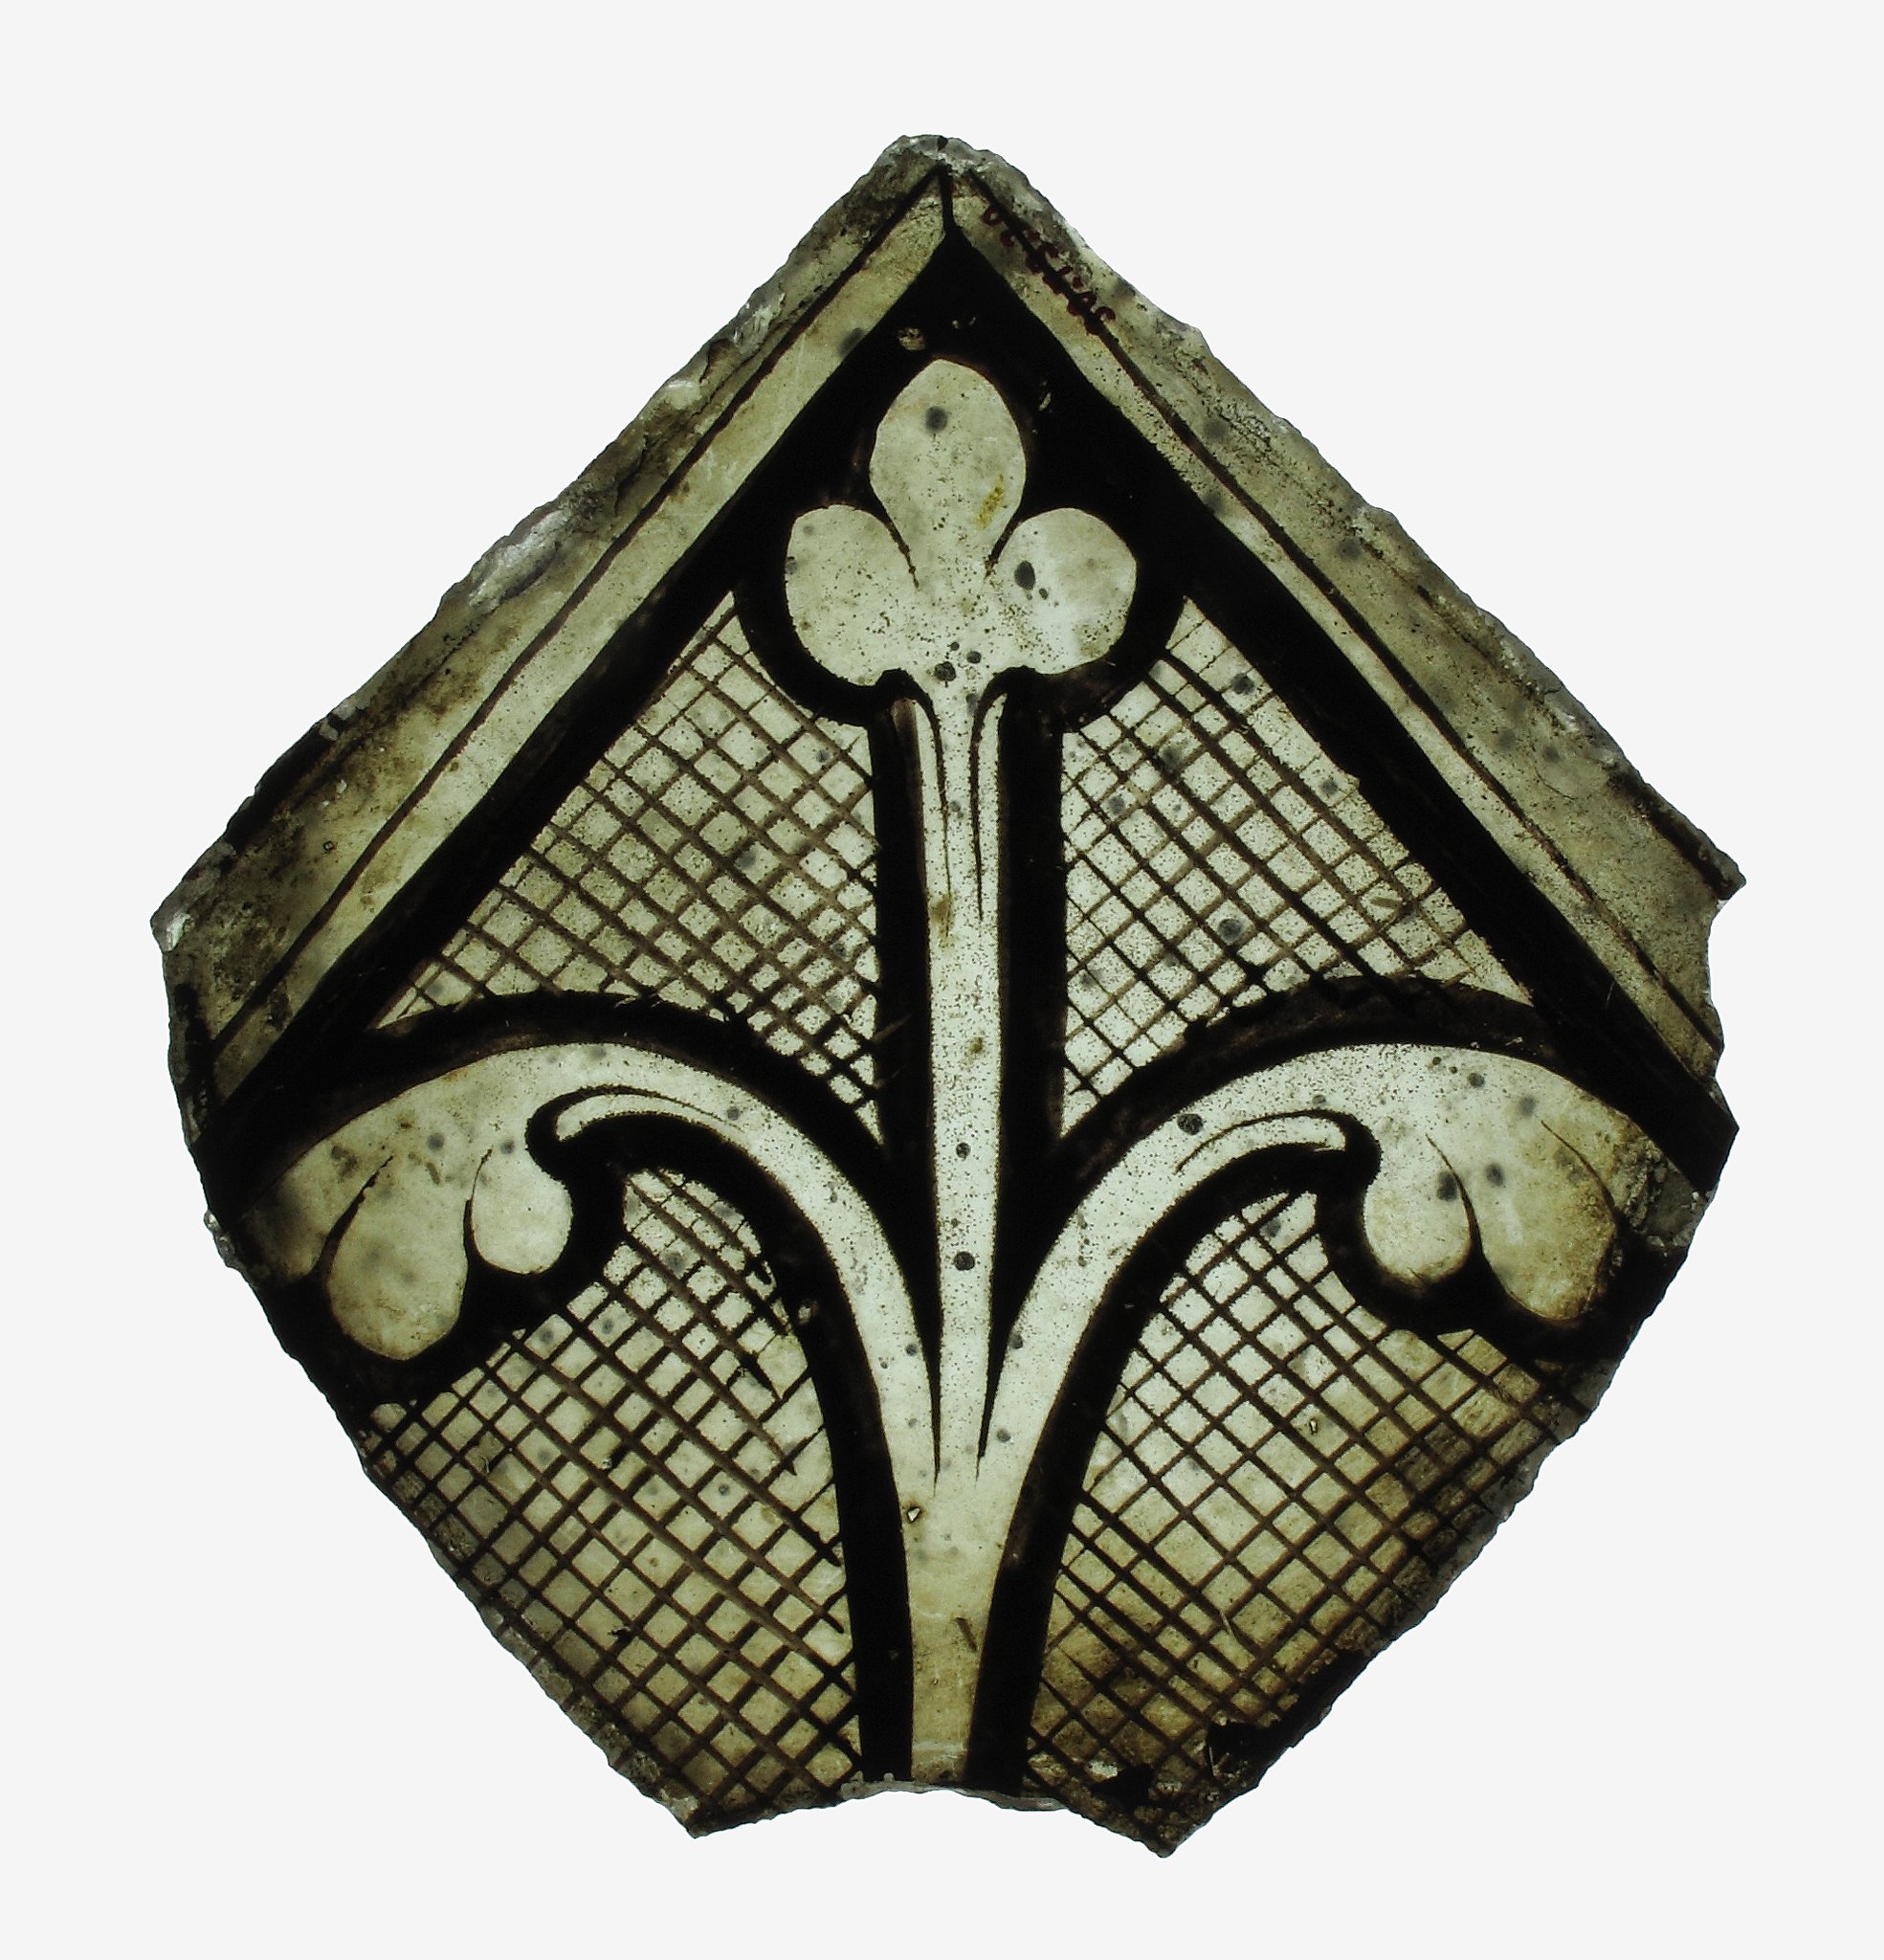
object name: fragment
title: Glass Fragment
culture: british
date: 1290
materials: glass